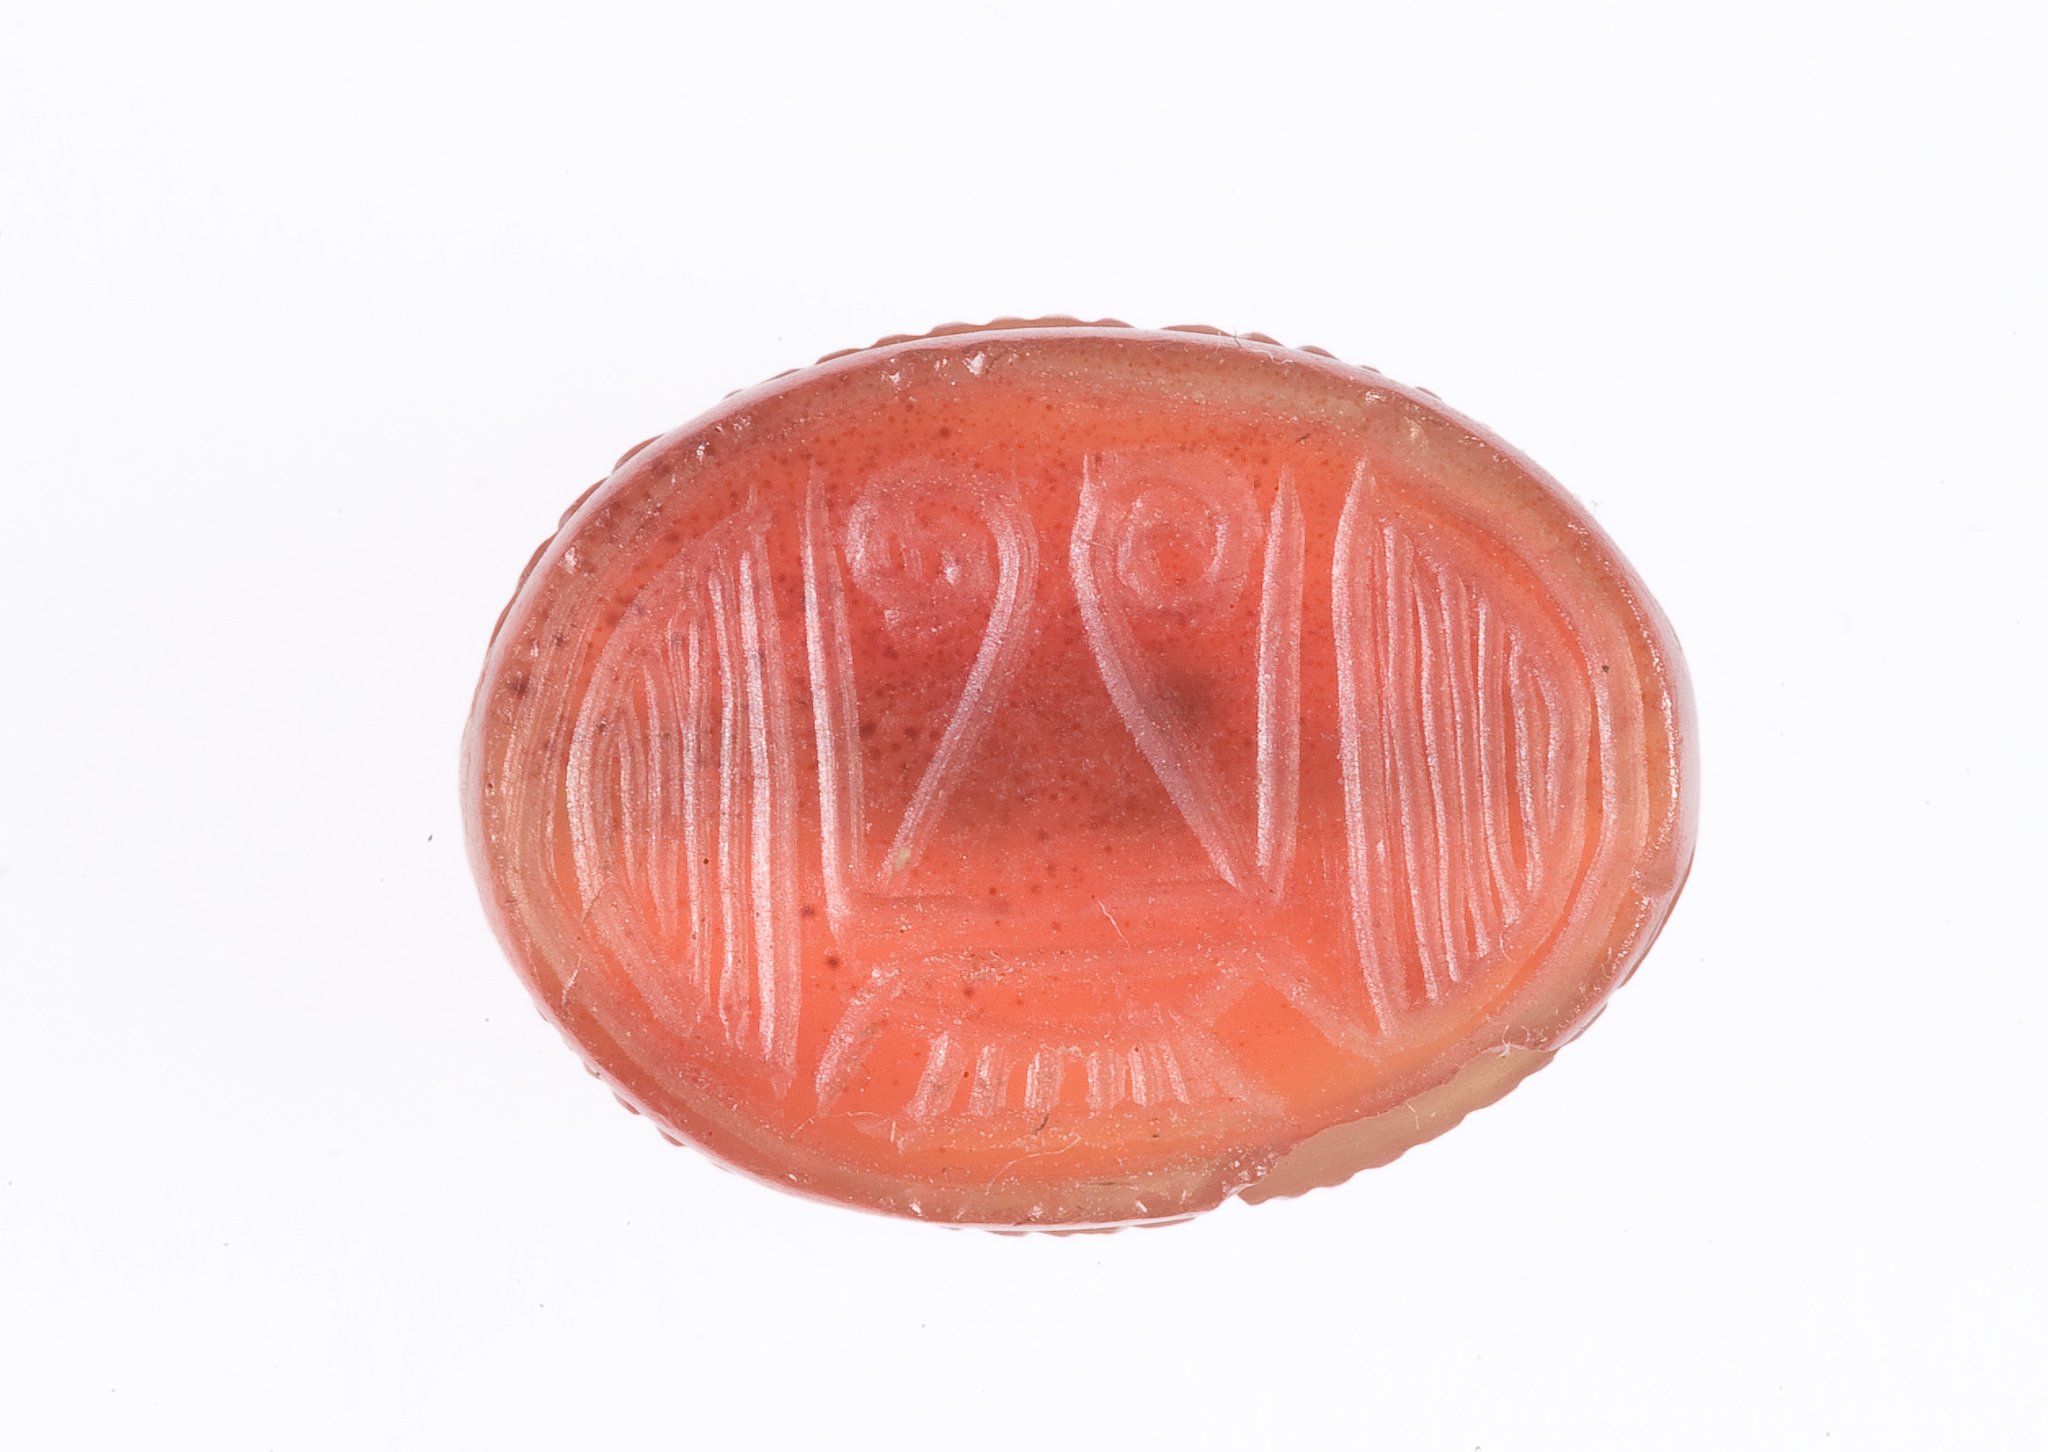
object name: scarab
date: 1635-1458 BCE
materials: gemstone, jasper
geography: egypt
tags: scarabs